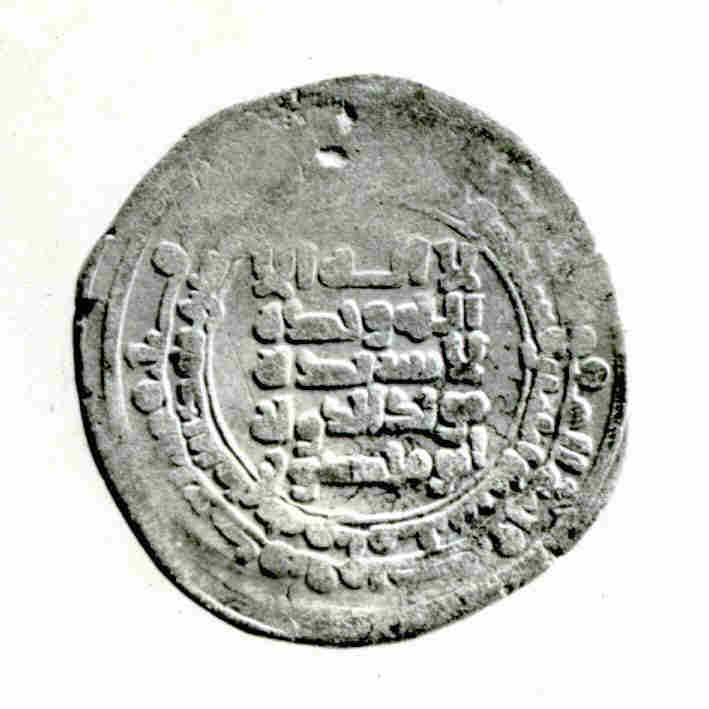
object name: coin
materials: silver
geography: amul